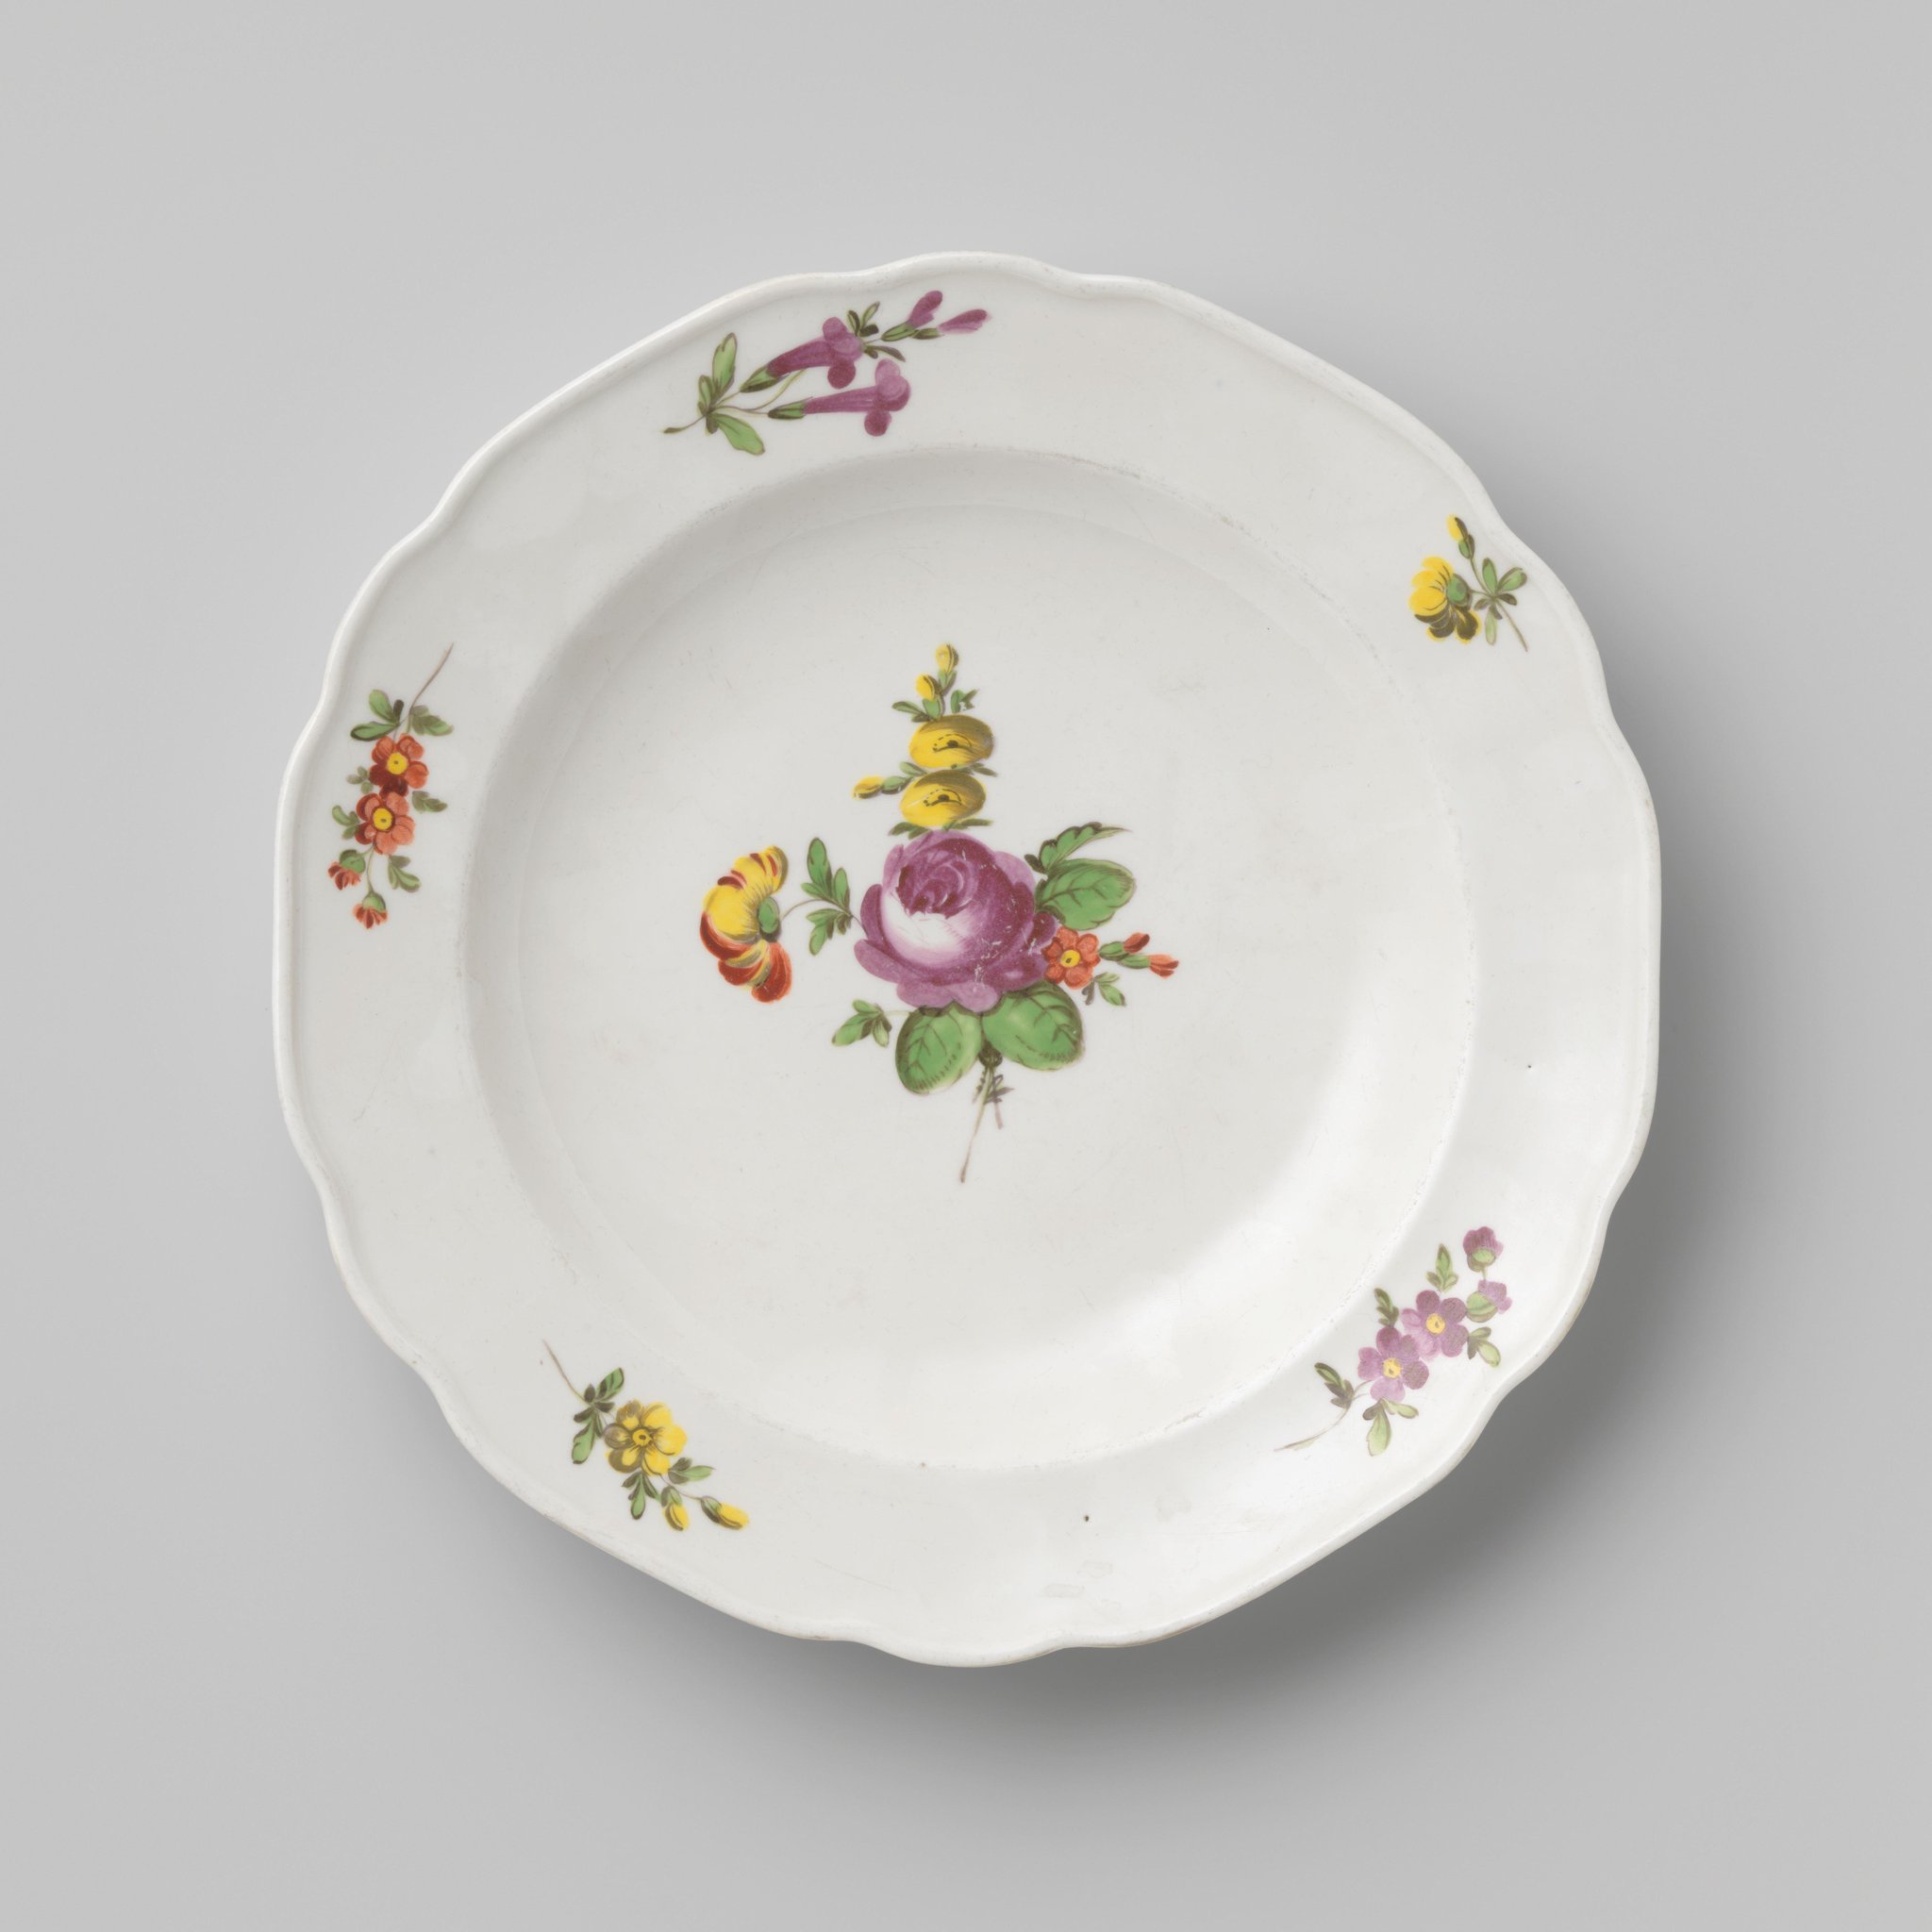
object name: plate dish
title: Plate with a bouquet and flower sprays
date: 1800-1849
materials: glaze, paint, porcelain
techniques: firing, forming, turning, vitrification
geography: vienna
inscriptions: mark: ‘schild/ A/ 38/ 33’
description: Bord van porselein met een gelobde rand, beschilderd op het glazuur in rood, groen, geel en paars. Op het plat een boeket van verschillende bloemen (o.a. pioenroos) omgeven door losse takjes en op de rand vijf bloemtakken. Gemerkt op de onderzijde met het schild, de letter A en de nummers 38 en 33.